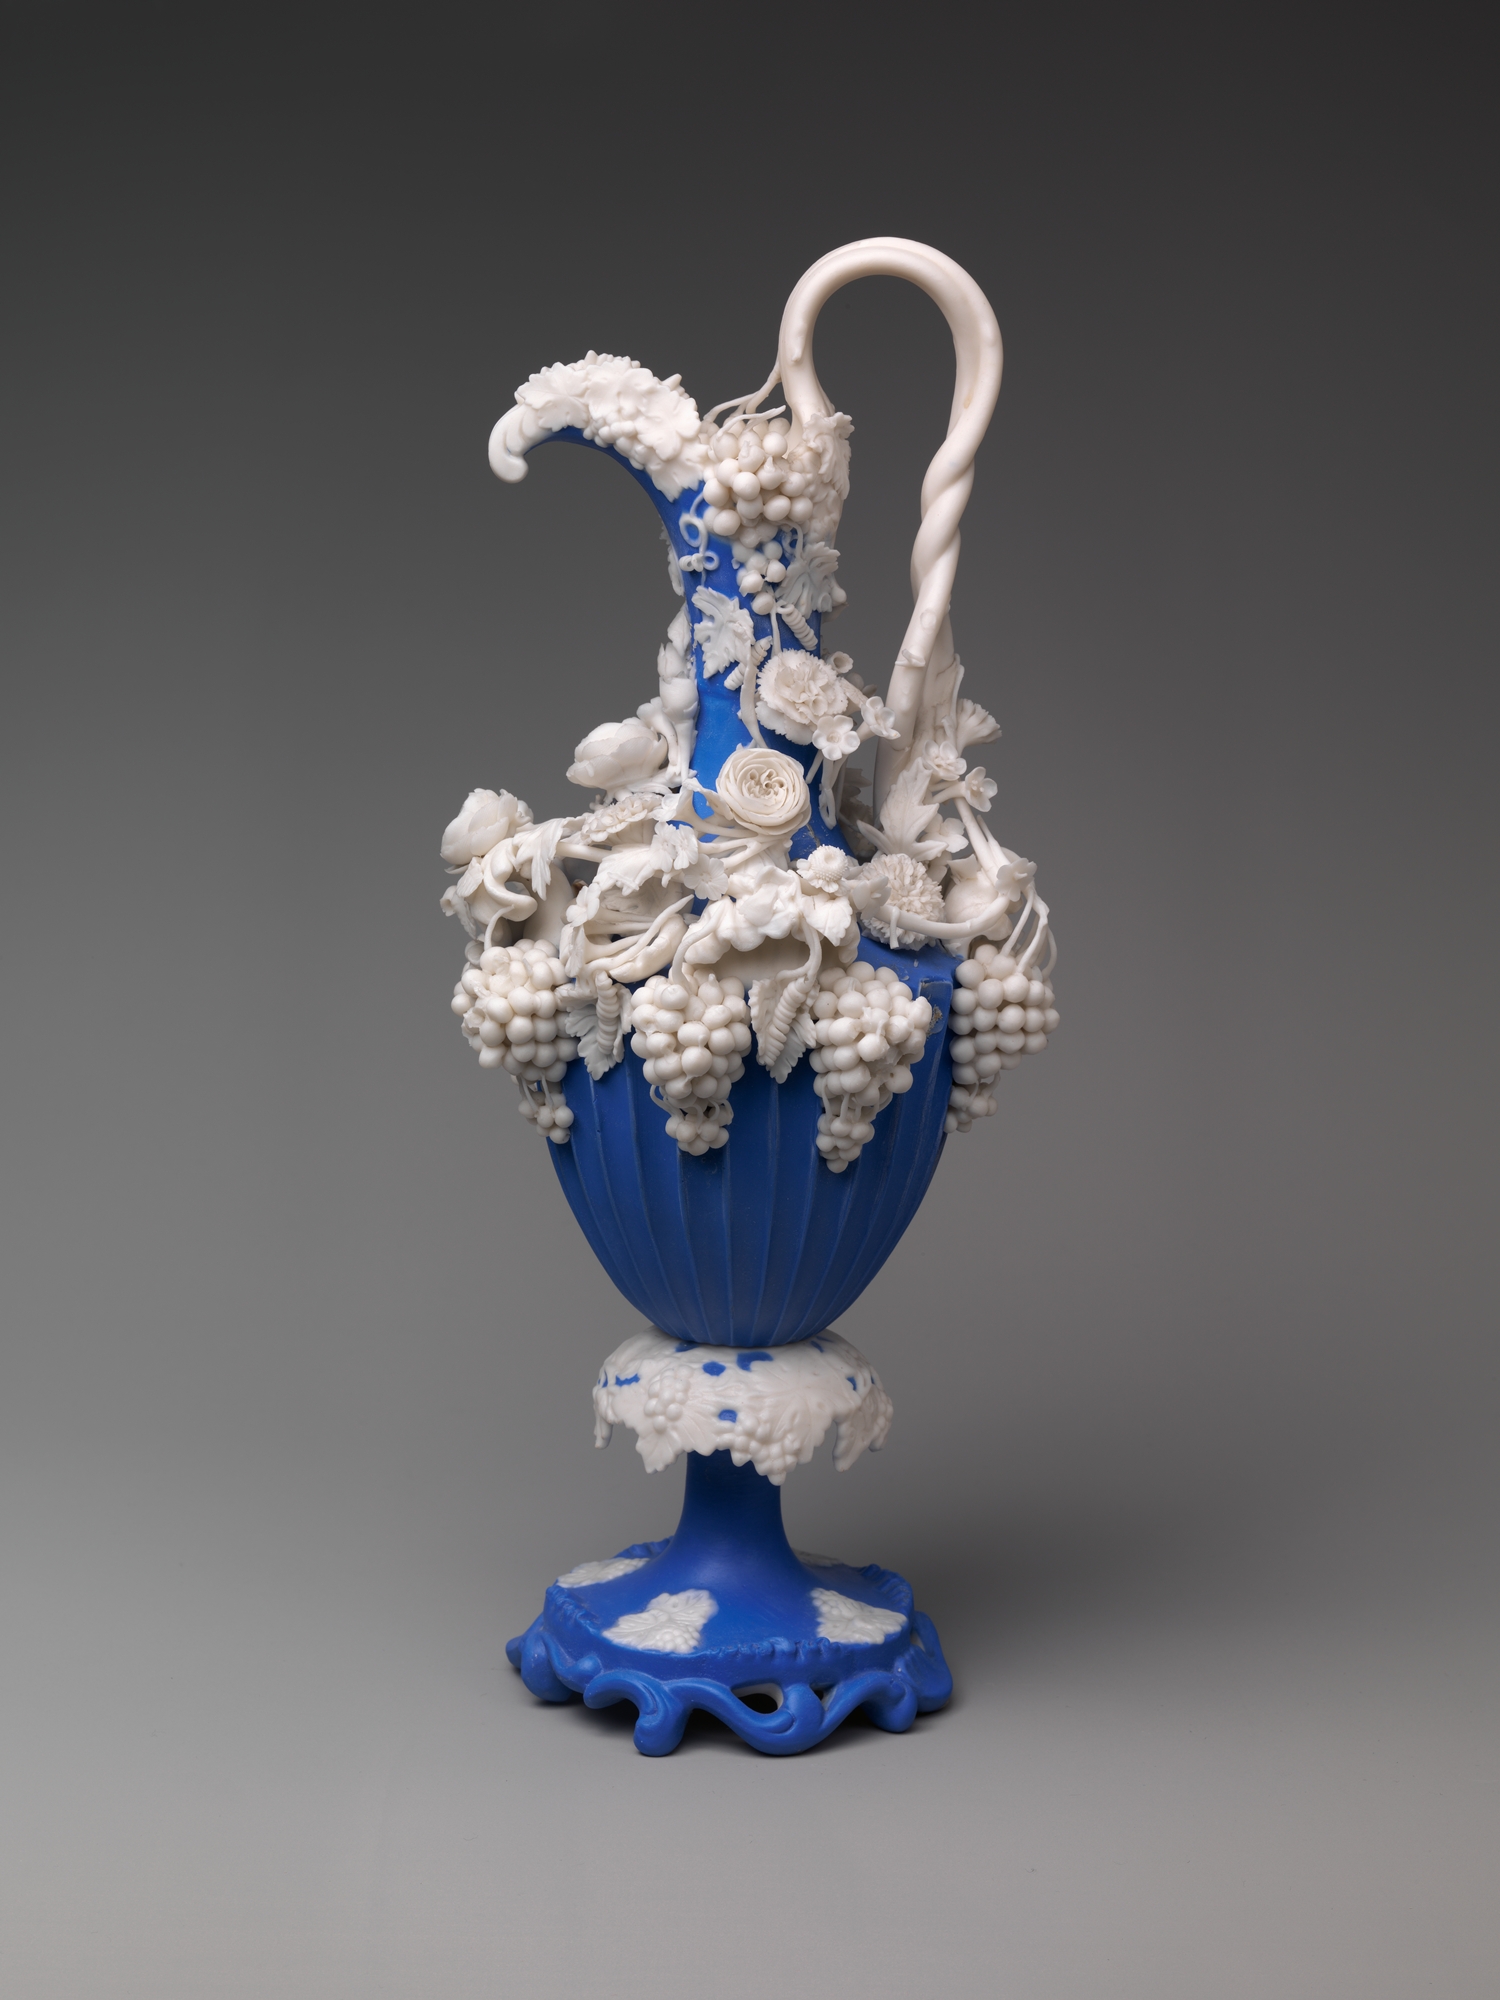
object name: ewer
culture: american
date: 1830-1870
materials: porcelain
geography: united states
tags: grapes,flowers